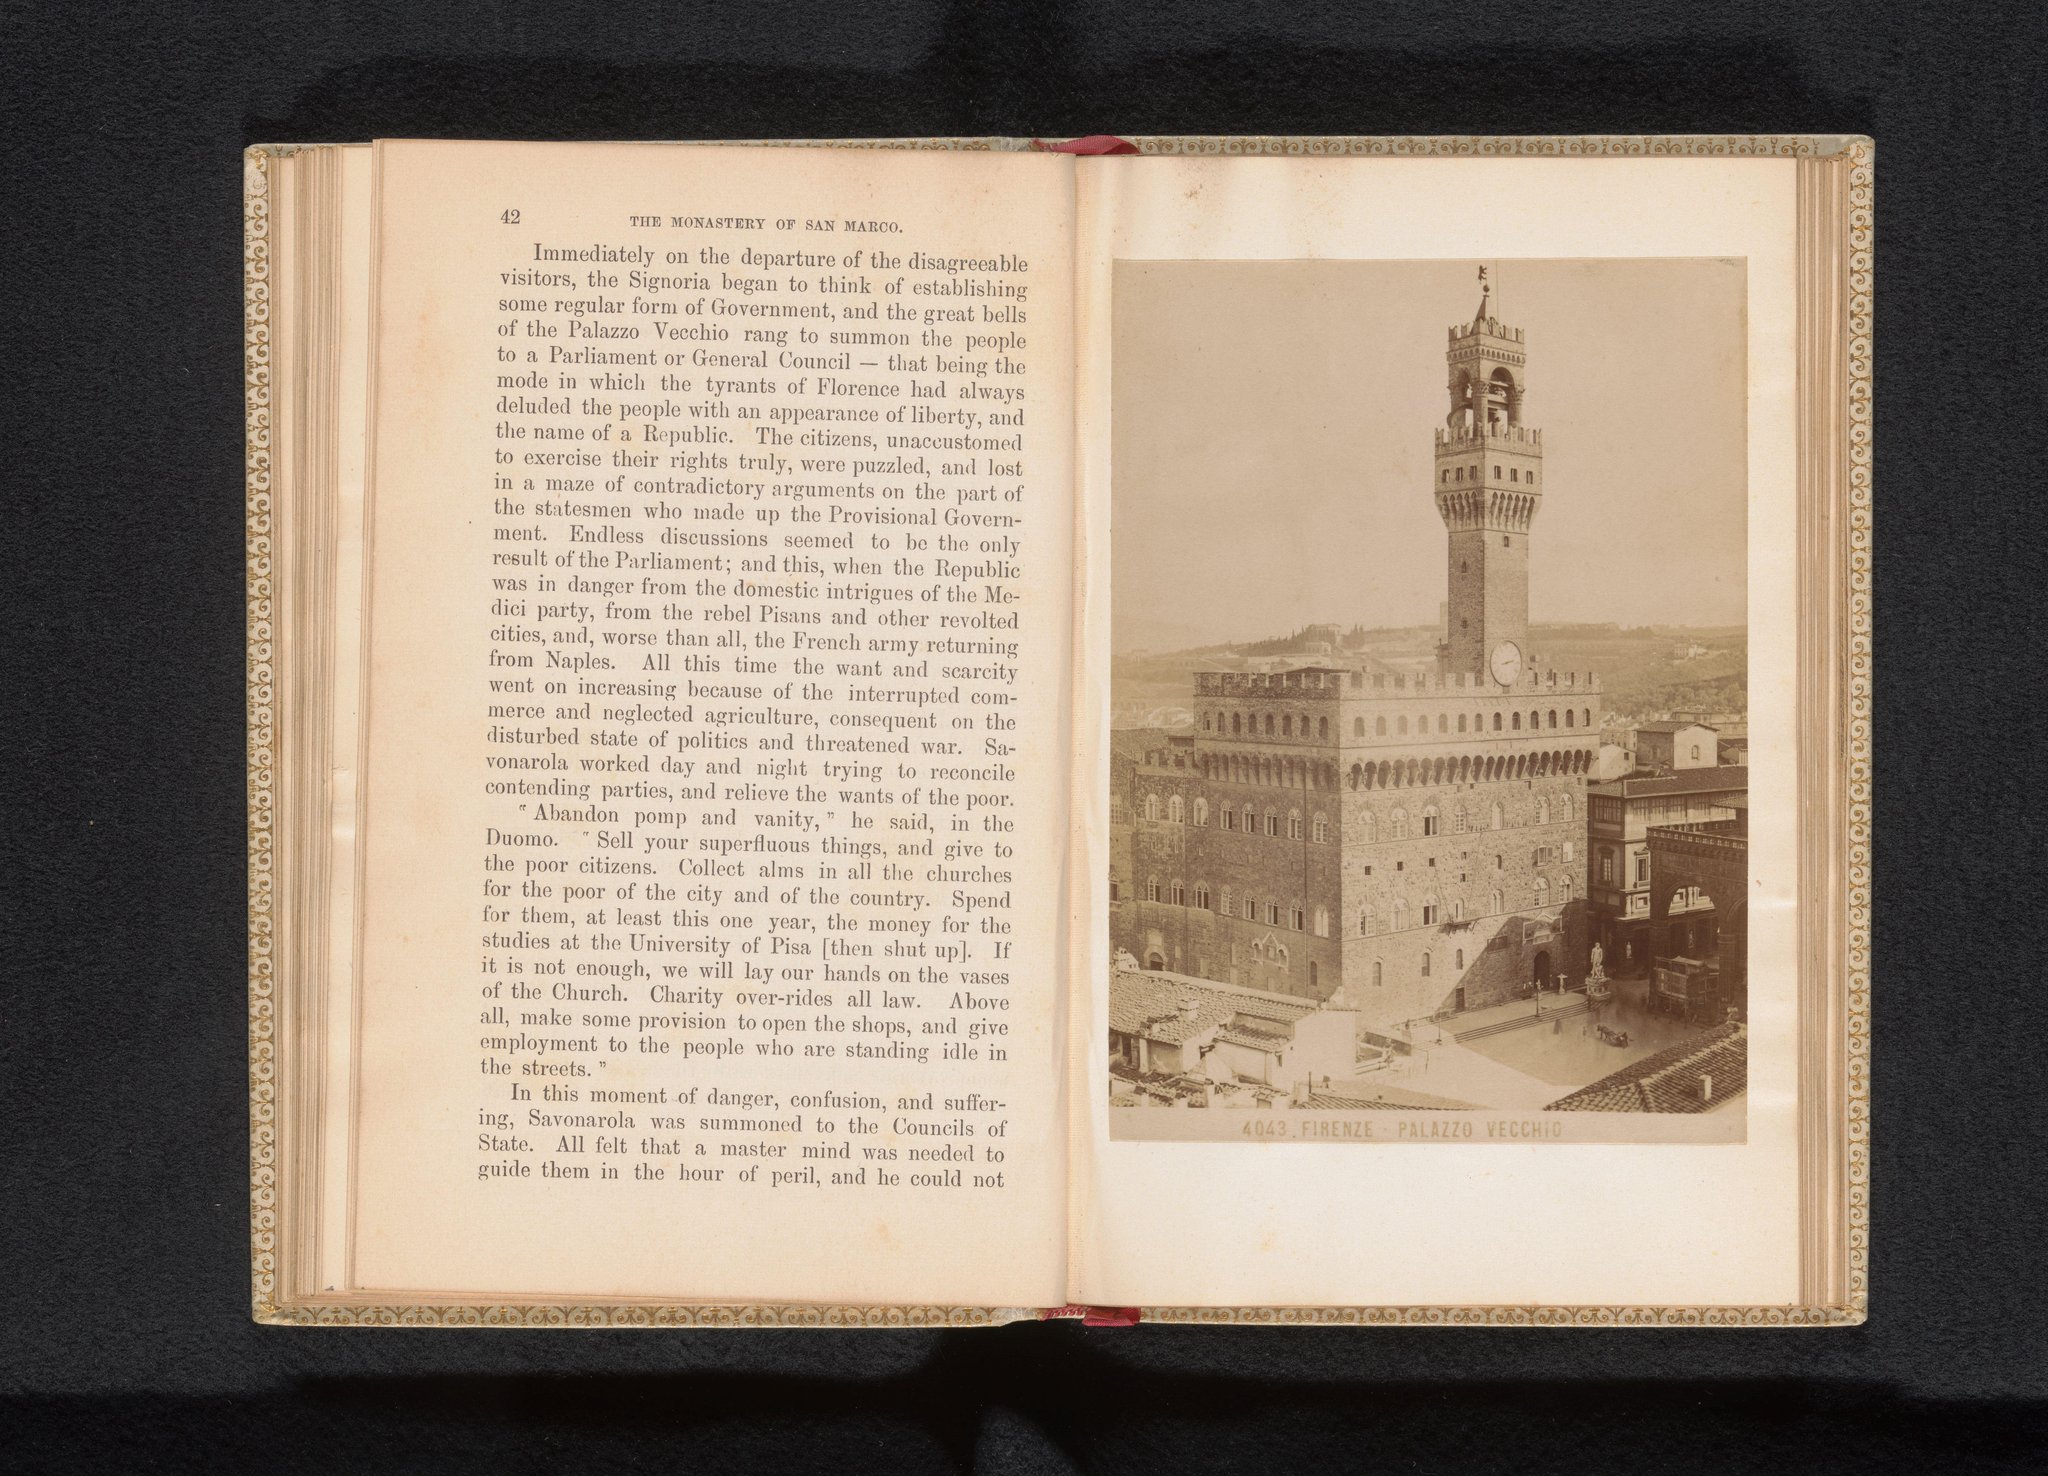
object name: page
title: Exterieur van het Palazzo Vecchio te Florence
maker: Anonymous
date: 1880-1890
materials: photographic support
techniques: albumen print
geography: florence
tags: hôtel, i.e. small palace in city, façade (of house or building)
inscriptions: number: ‘4043.’